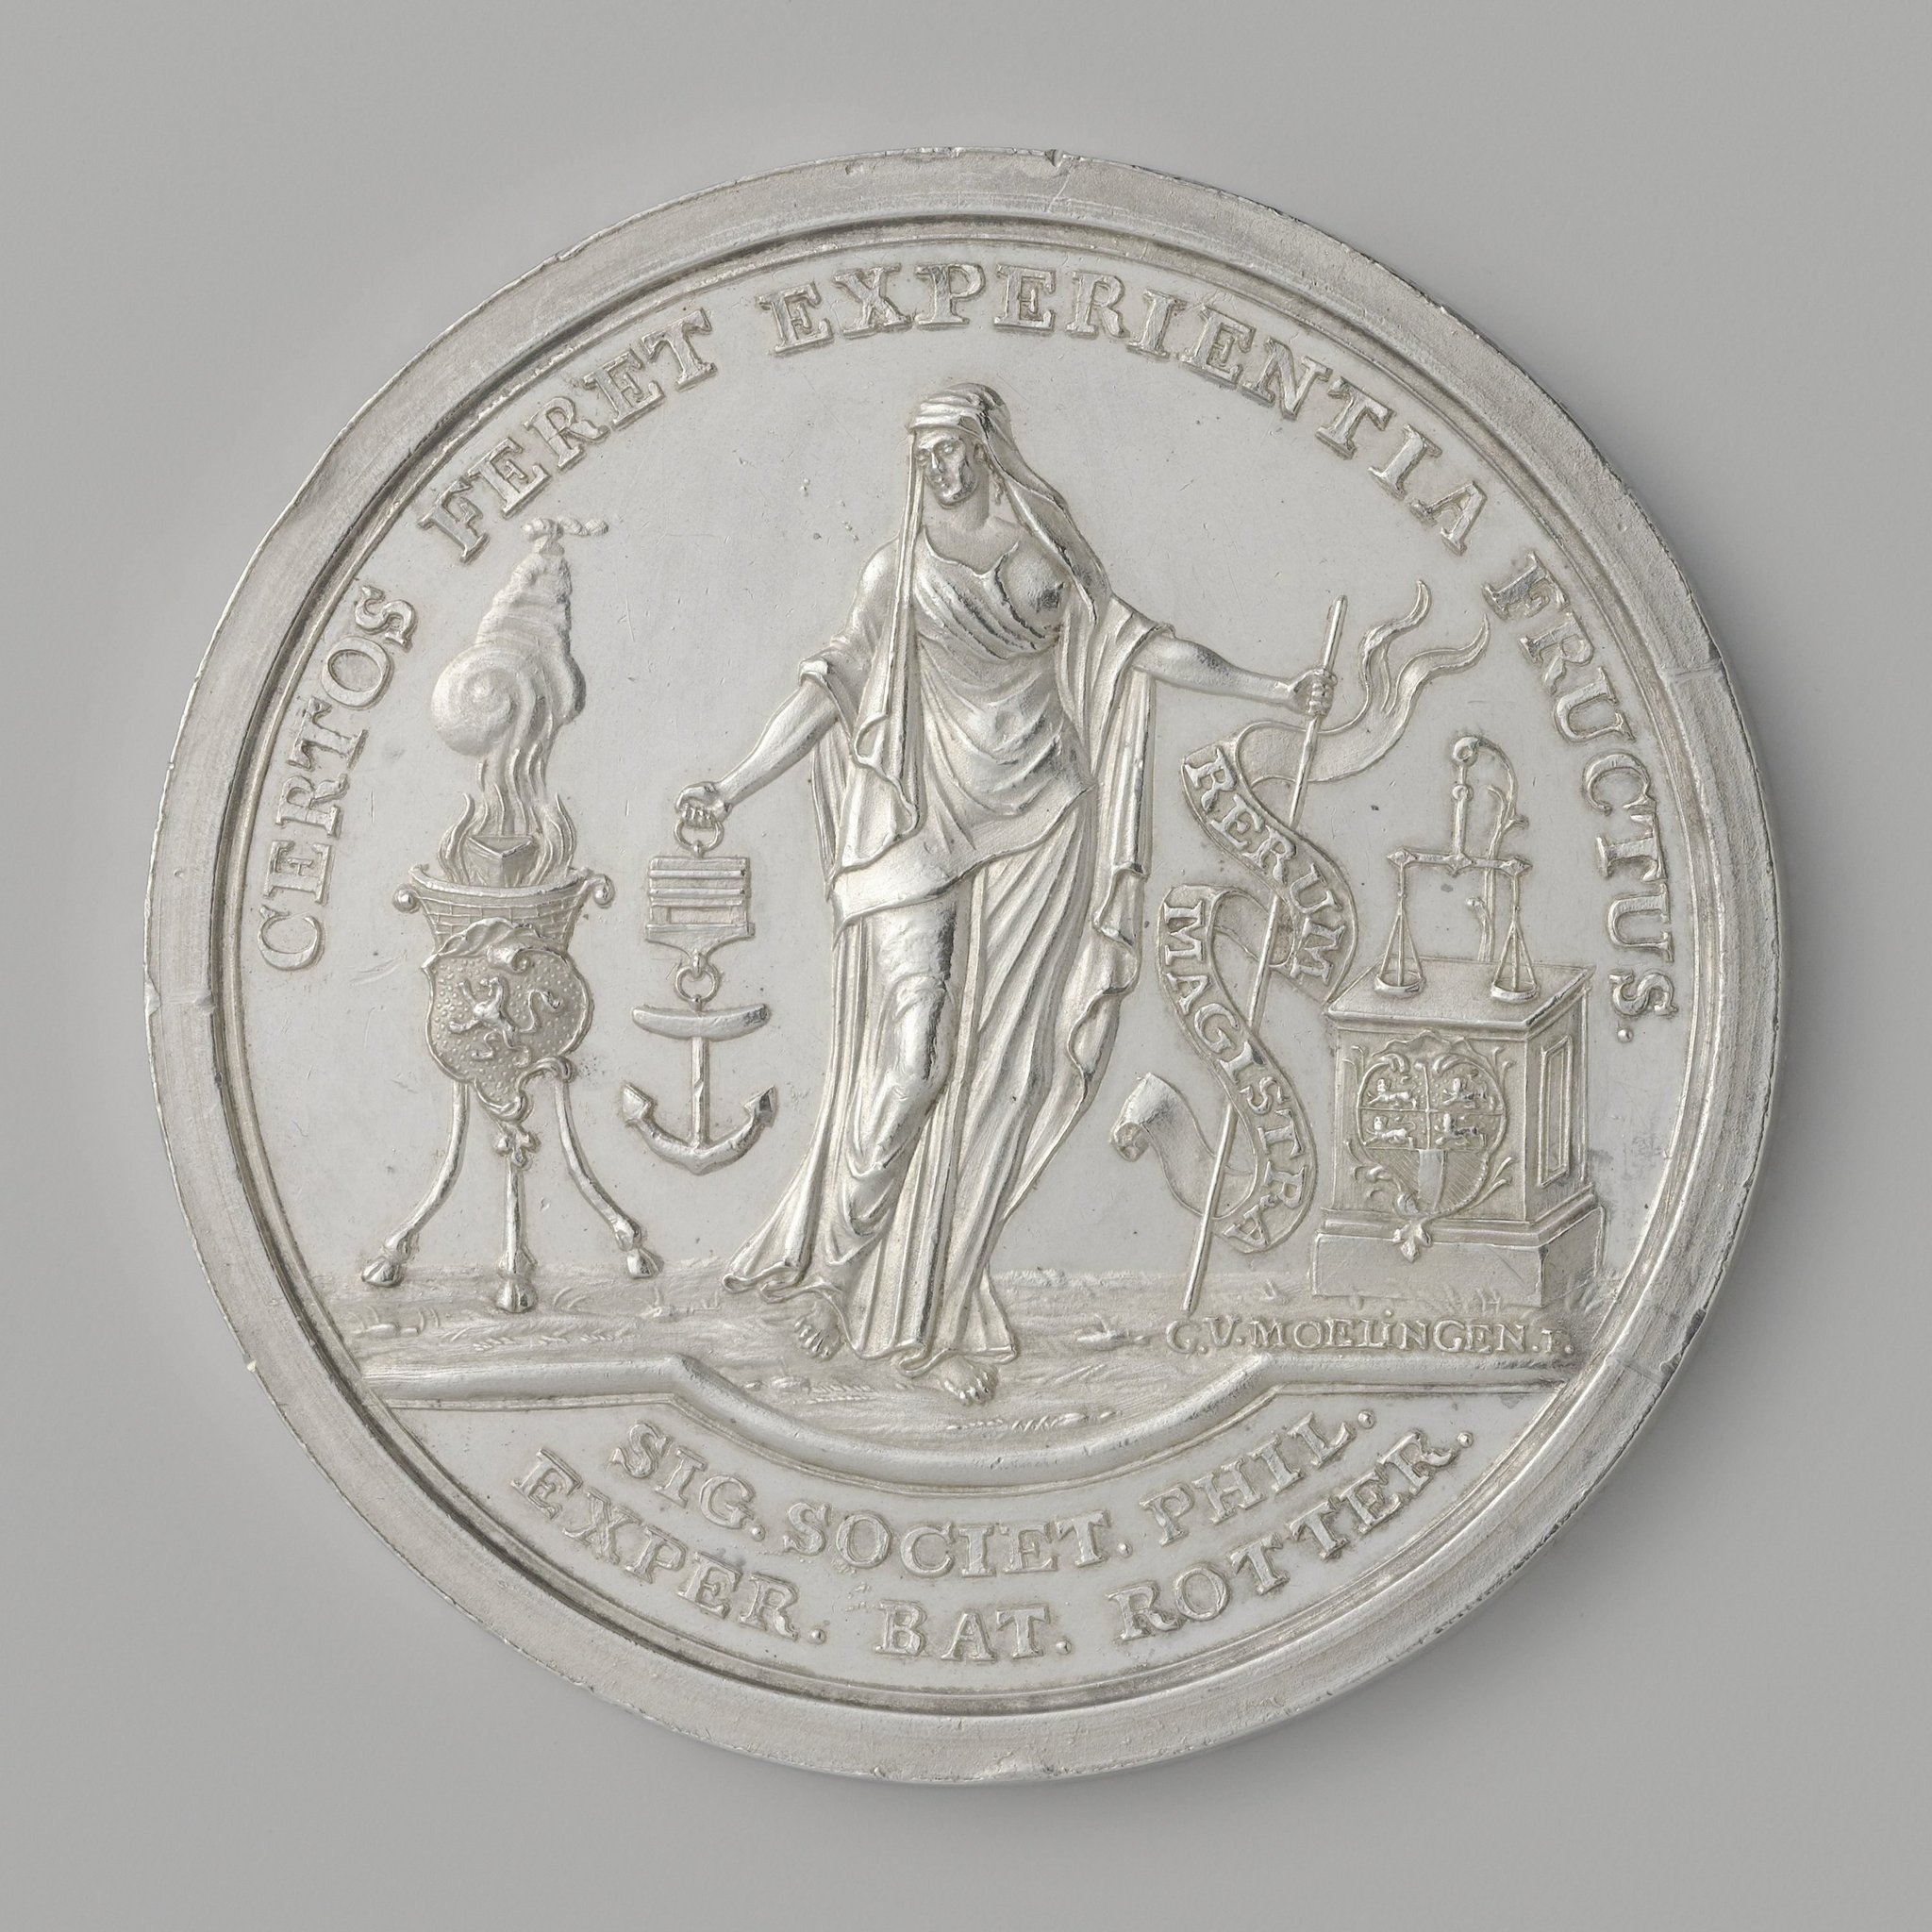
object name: medal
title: Bataafsch Genootschap van proefondervindelijke wijsbegeerte, penning toegekend aan B. Tiboel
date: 1779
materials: silver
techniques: striking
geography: the hague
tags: experience, mastery; 'esperienza' (ripa), rotterdam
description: Prize medal silver, 1779 Awarded by the Bataafsch Genootschap der Proefondervindelijke Wijsbegeerte, the society of 'experimental philosophy', of Rotterdam to the apothecary Boudewijn Tieboel of Groningen for his treatise on the burning of gasses. The society, founded in 1779, aimed promoted industry, agriculture and shipping.